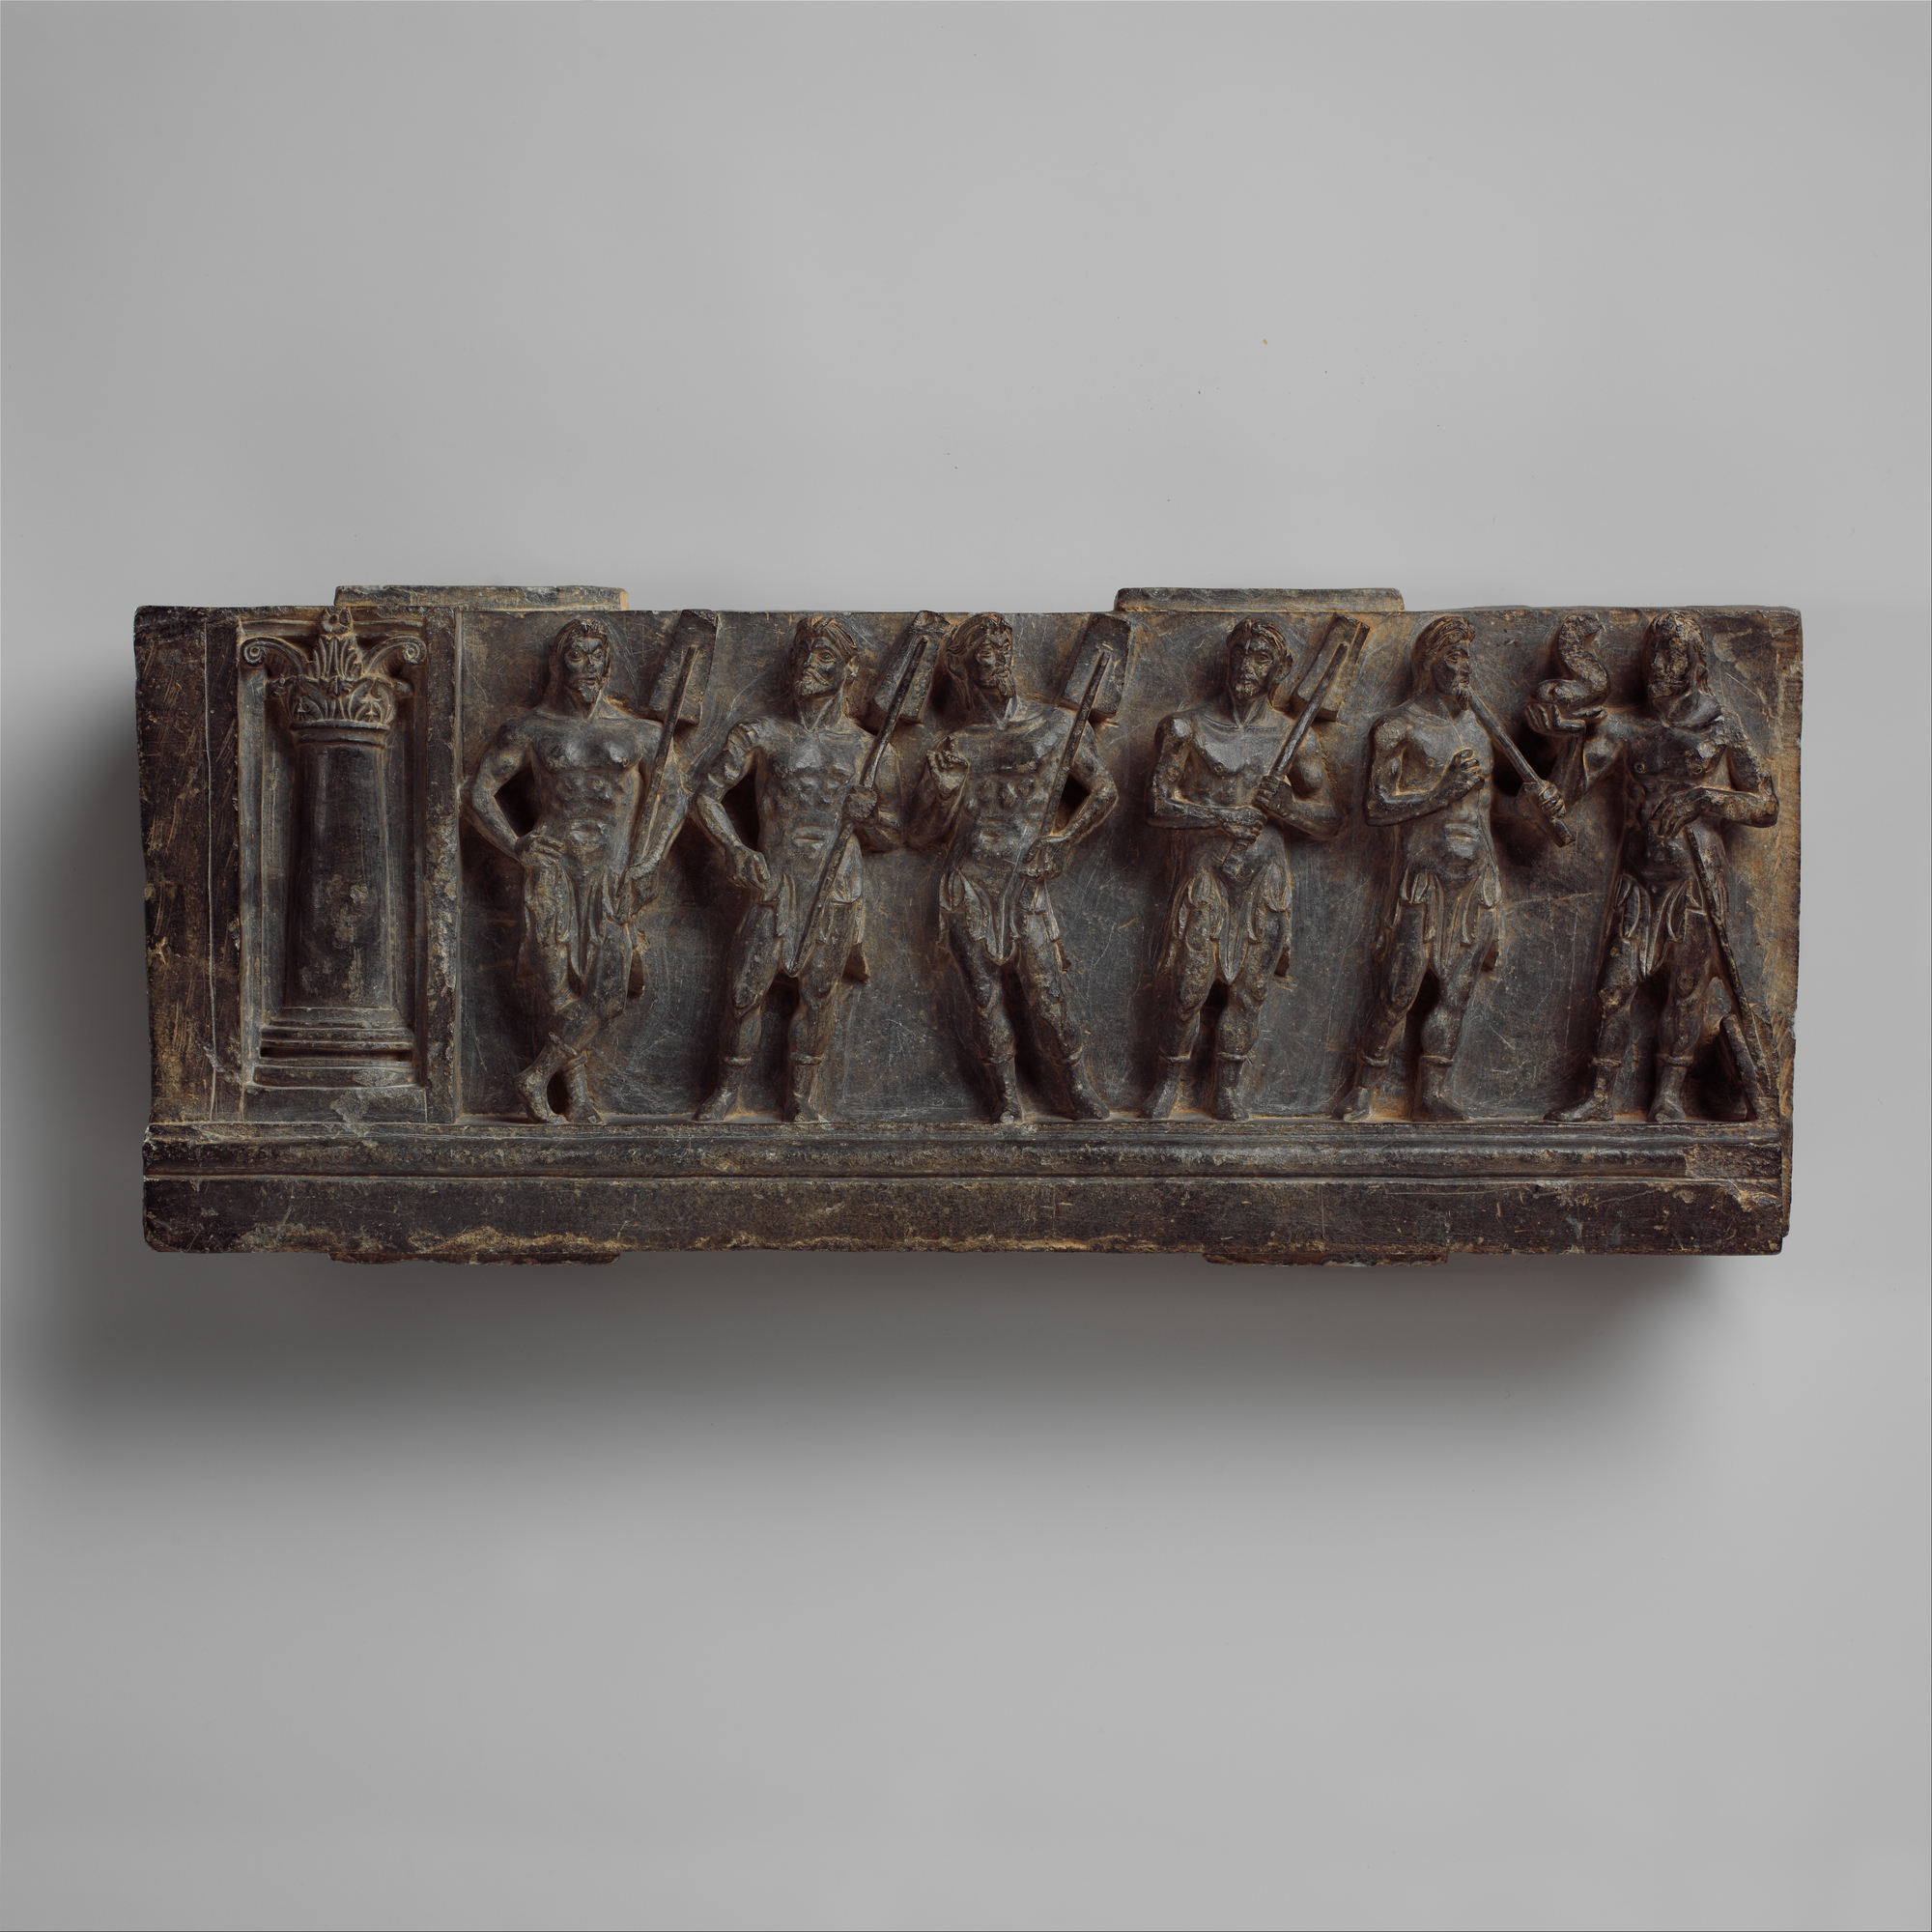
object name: stair riser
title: Stair Riser with Marine Deities or Boatmen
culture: pakistani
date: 1-100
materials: stone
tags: gandhara,men